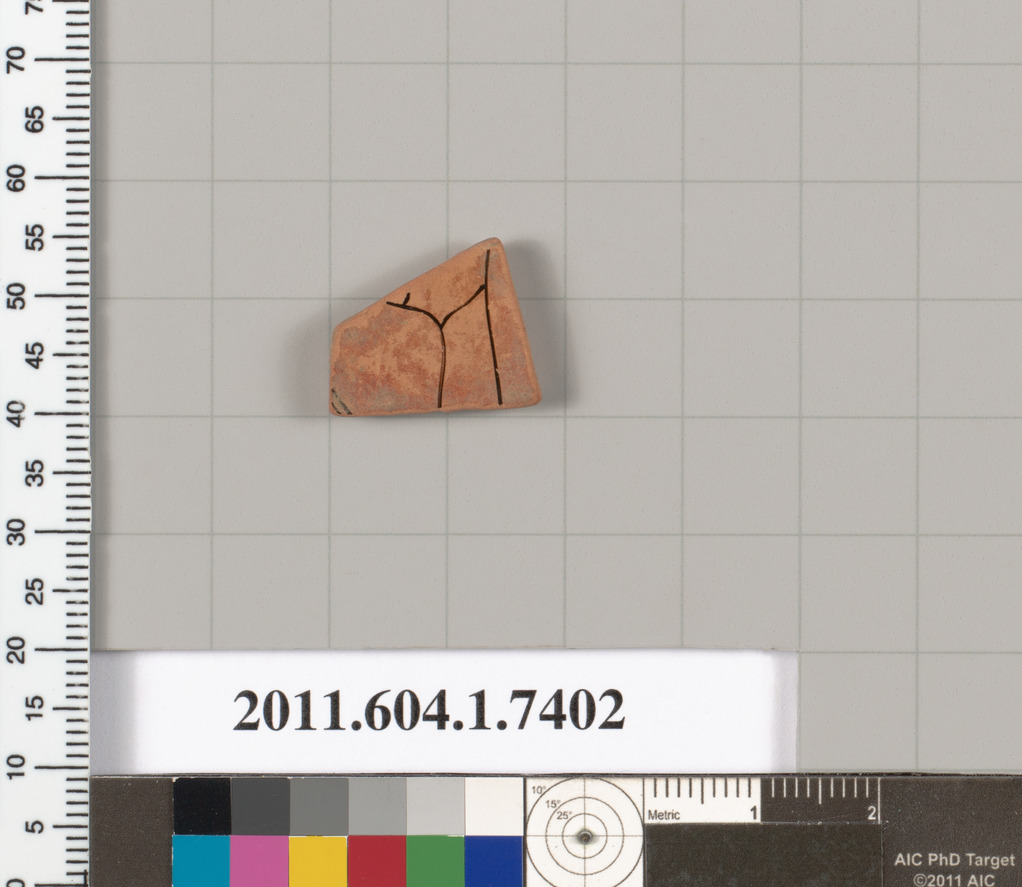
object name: kylix fragment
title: Terracotta fragment of a kylix (drinking cup)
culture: greek, attic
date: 500-480 BCE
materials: terracotta